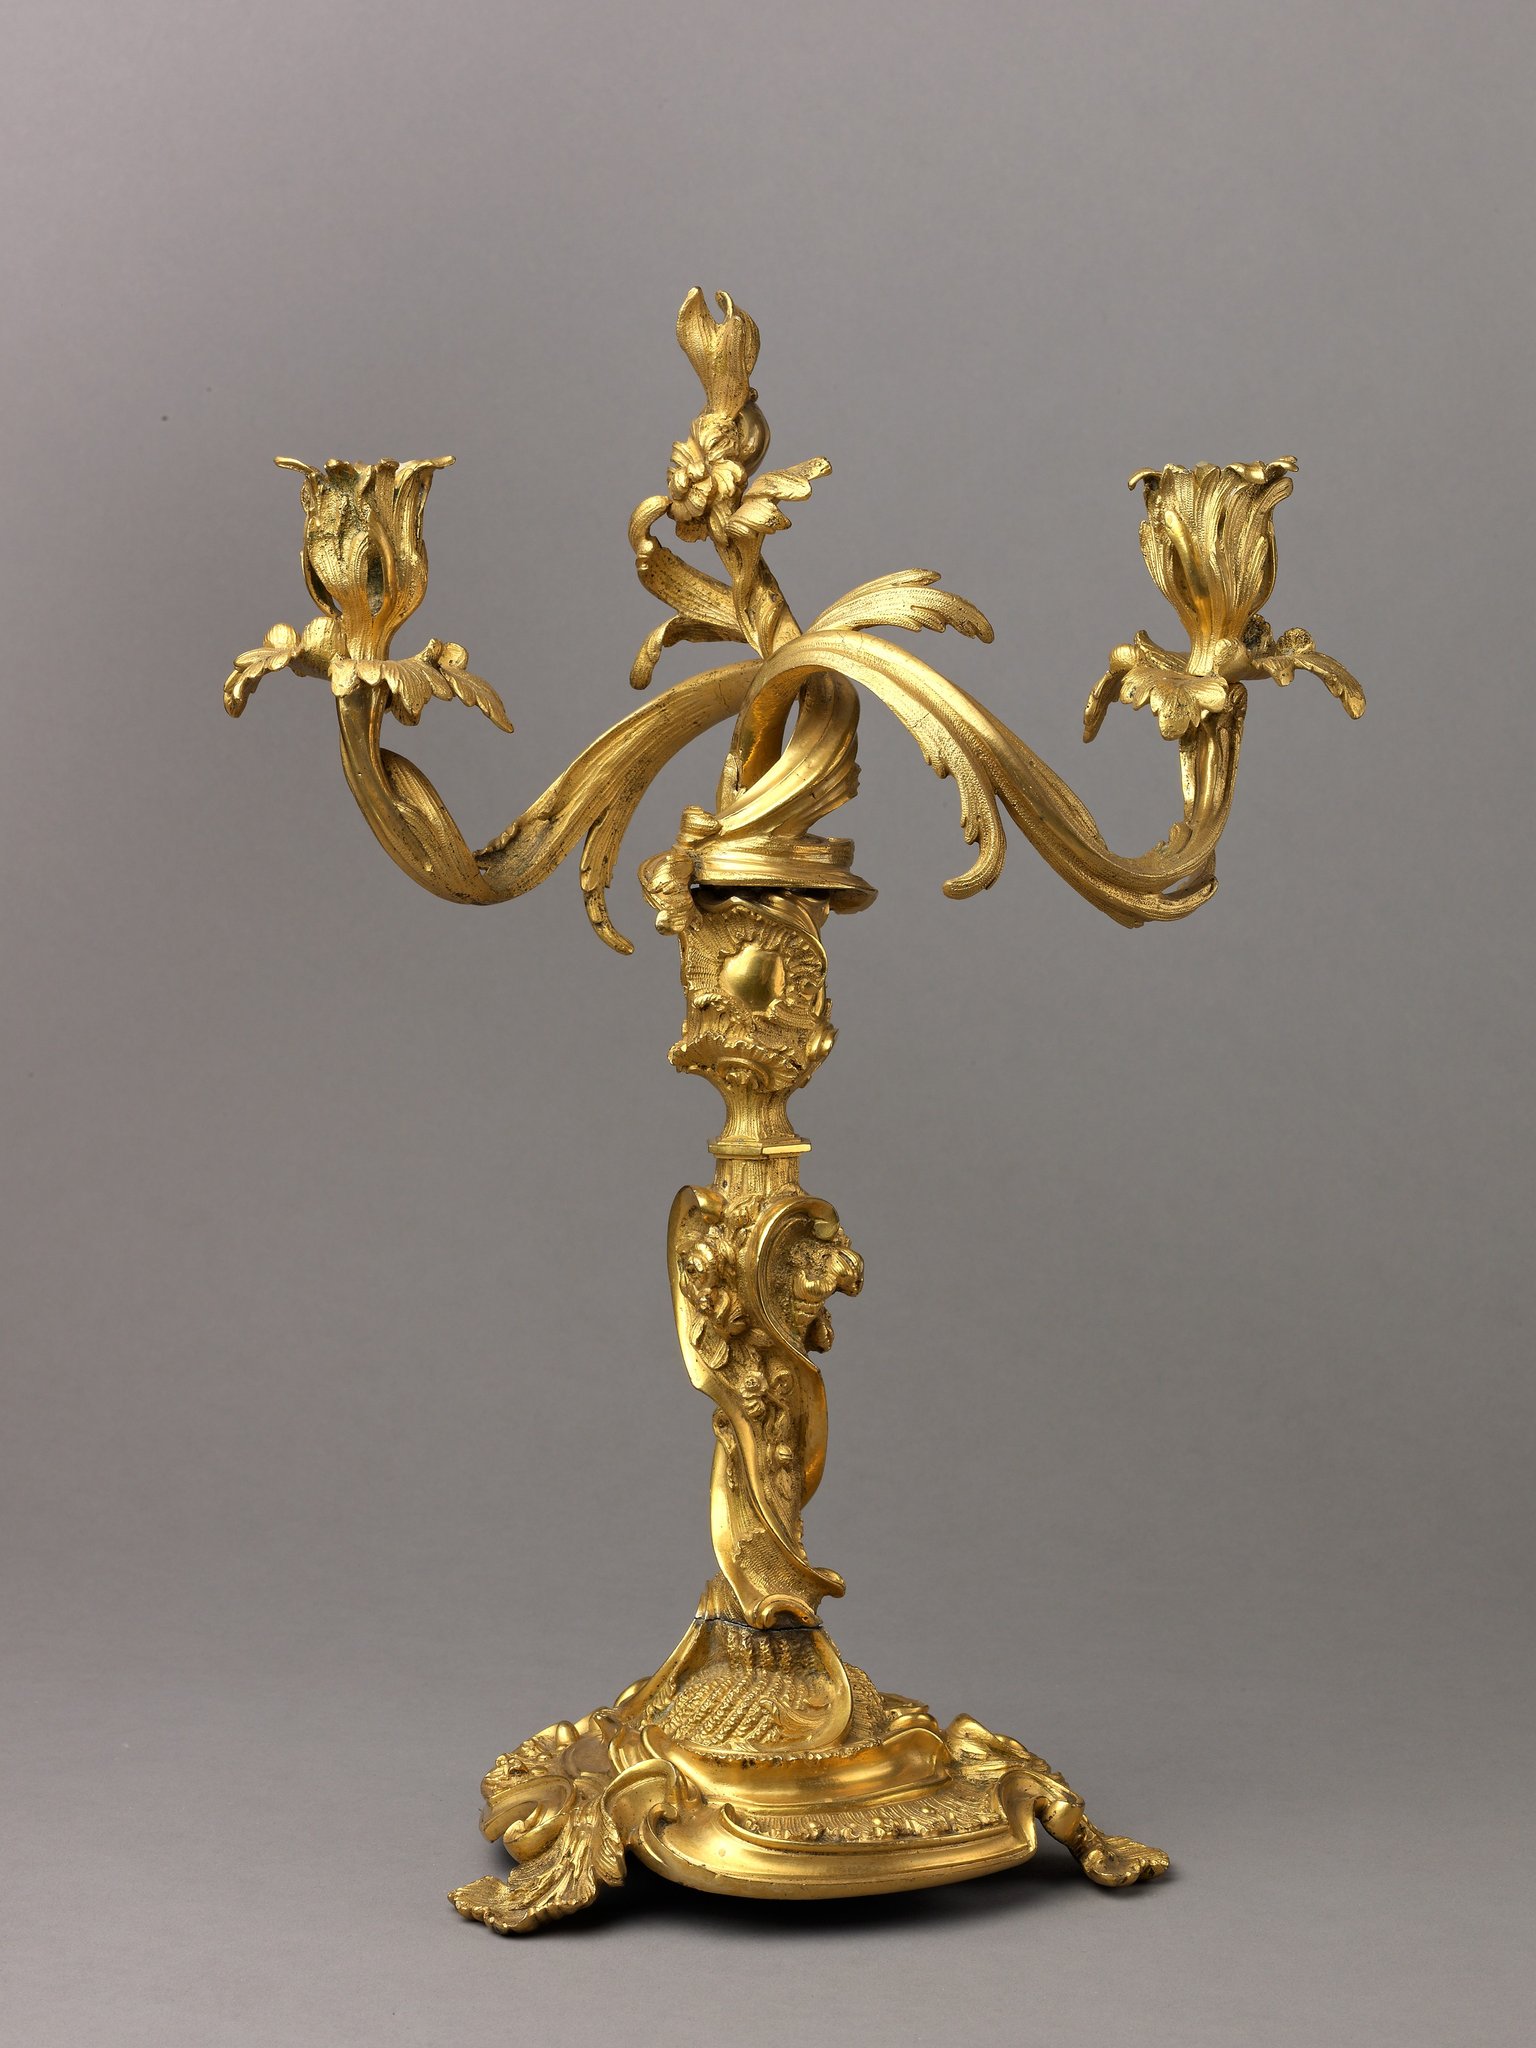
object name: candlestick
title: Candlestick with Two Branches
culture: french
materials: gilt bronze